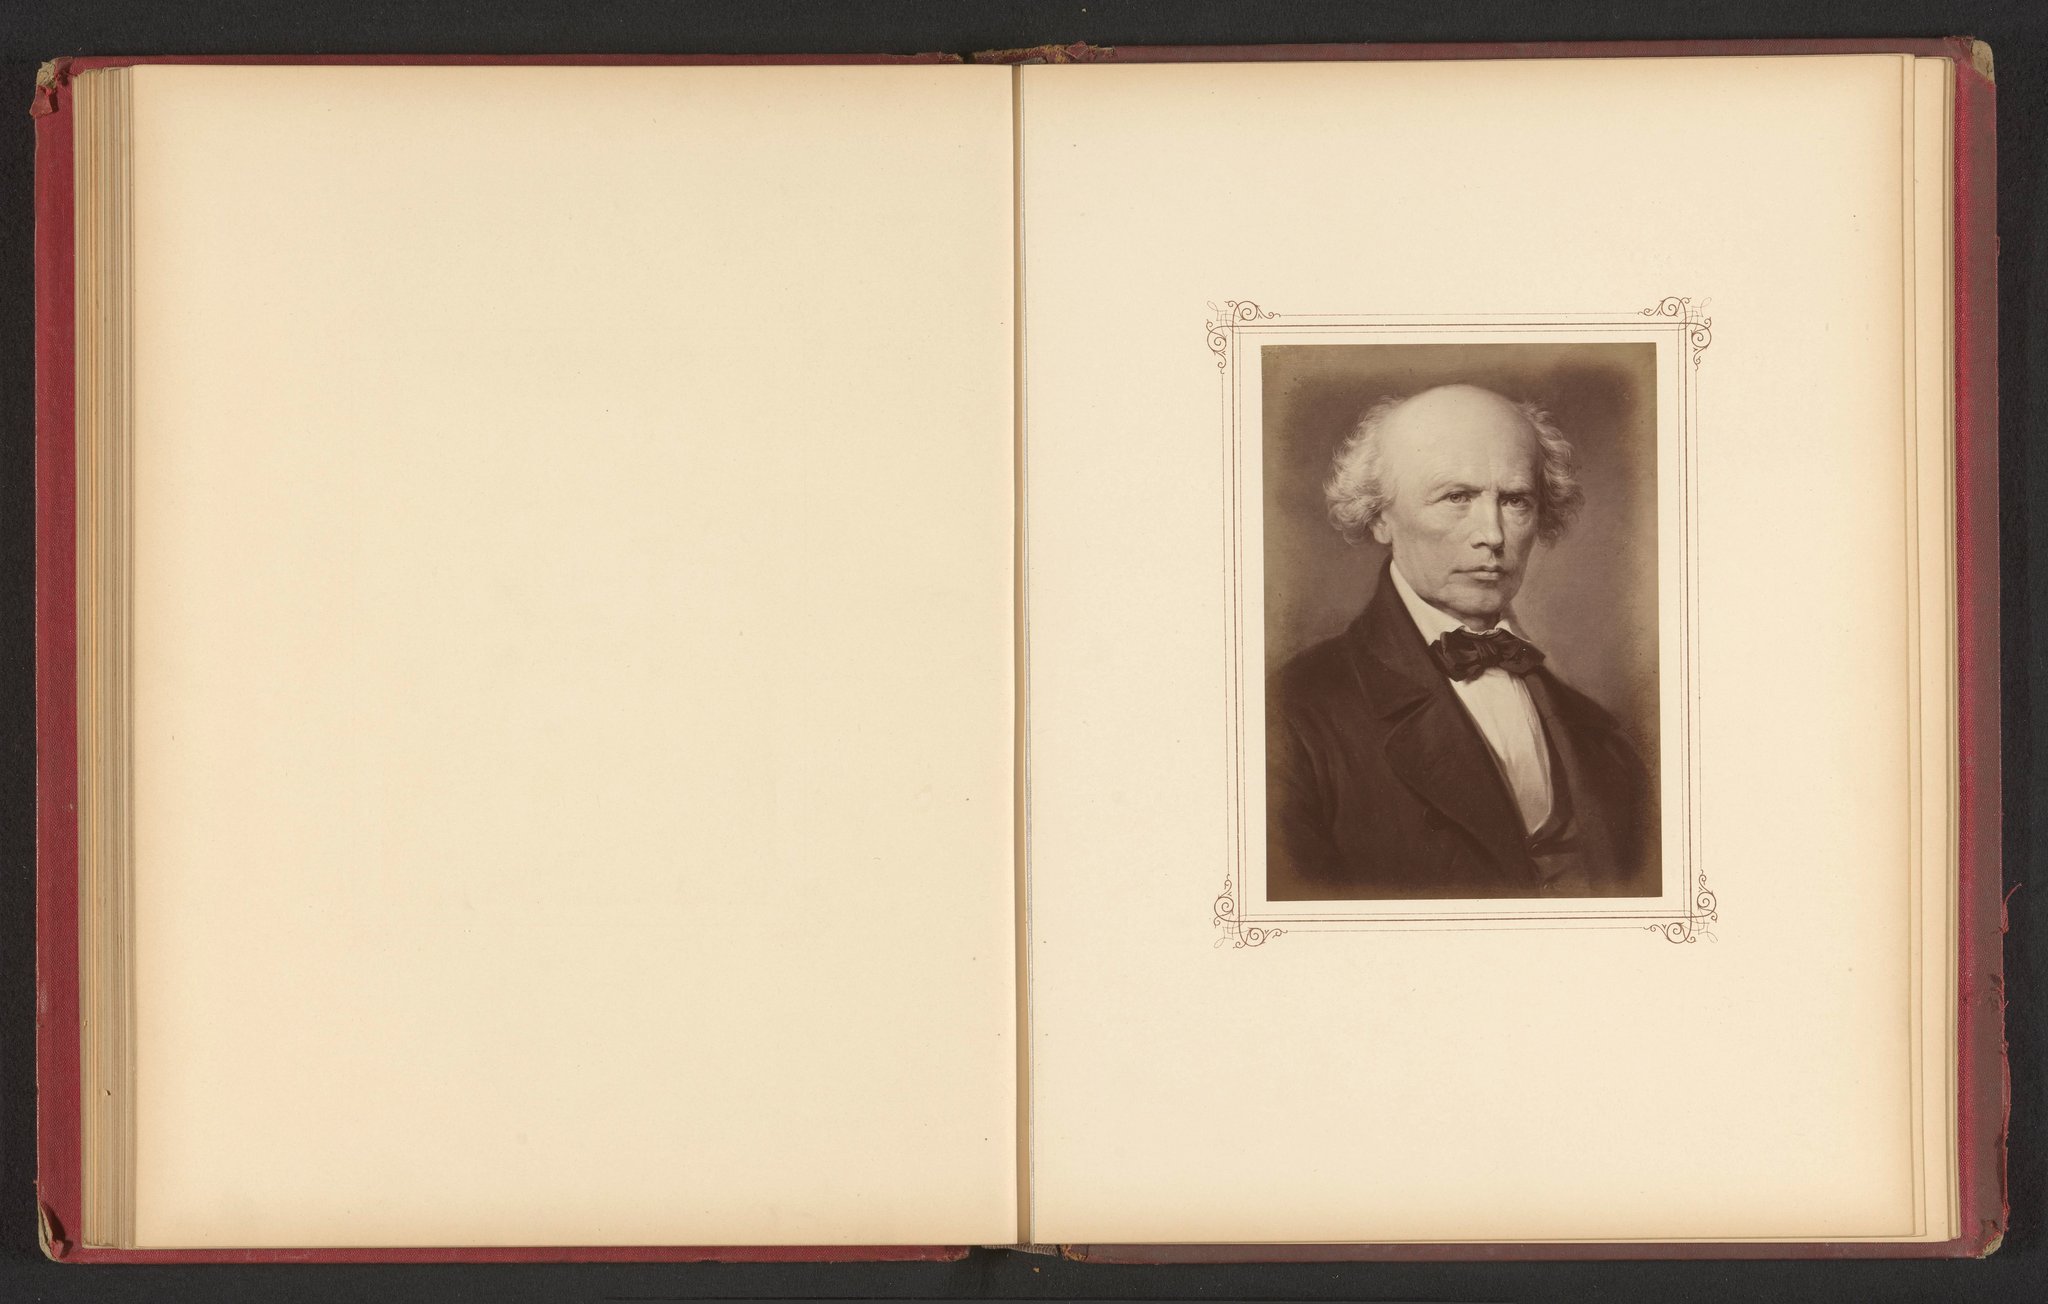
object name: photograph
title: Fotoreproductie van een portret van Ludwig Uhland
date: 1868-1878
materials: photographic support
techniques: albumen print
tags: writer, poet, author